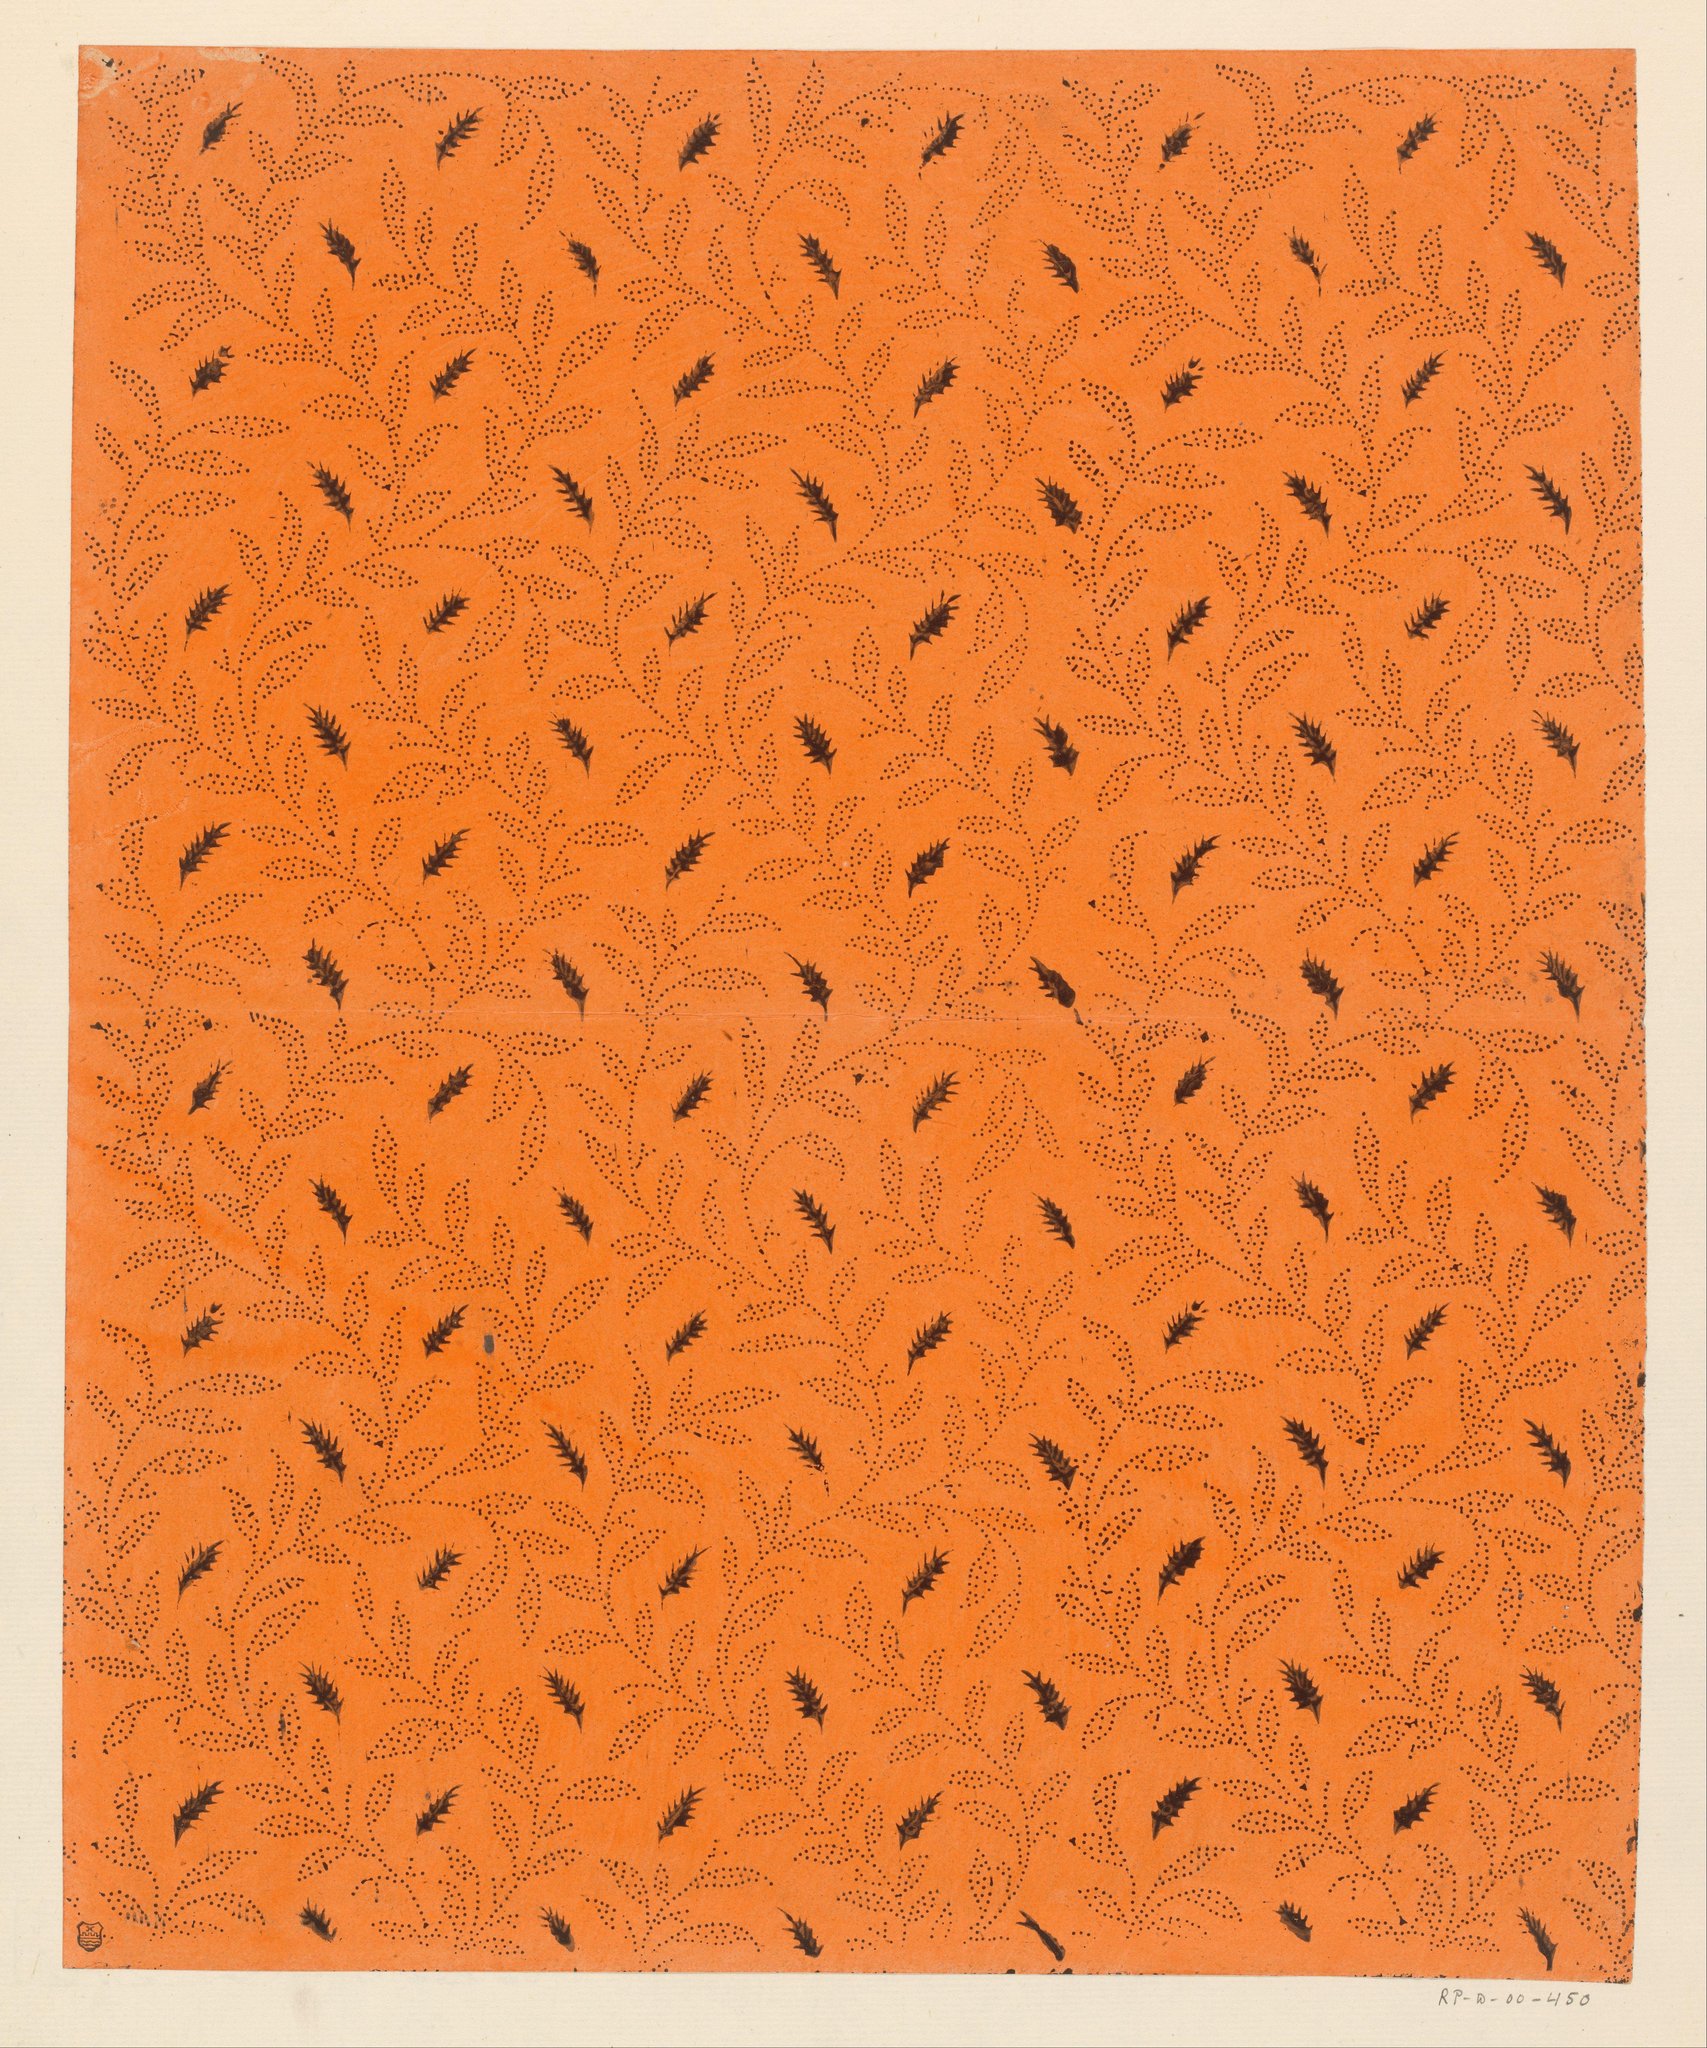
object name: printed paper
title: Blad met regelmatig slingerende ranken bestaande uit punten omgeven door blaadjes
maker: Anonymous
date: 1800-1900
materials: paint, paper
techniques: printing block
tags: ornament derived from plant forms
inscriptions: collector's mark: Lugt 2760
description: Blad met regelmatig over het blad slingerende ranken bestaande uit punten omgeven door hulstblaadjes.